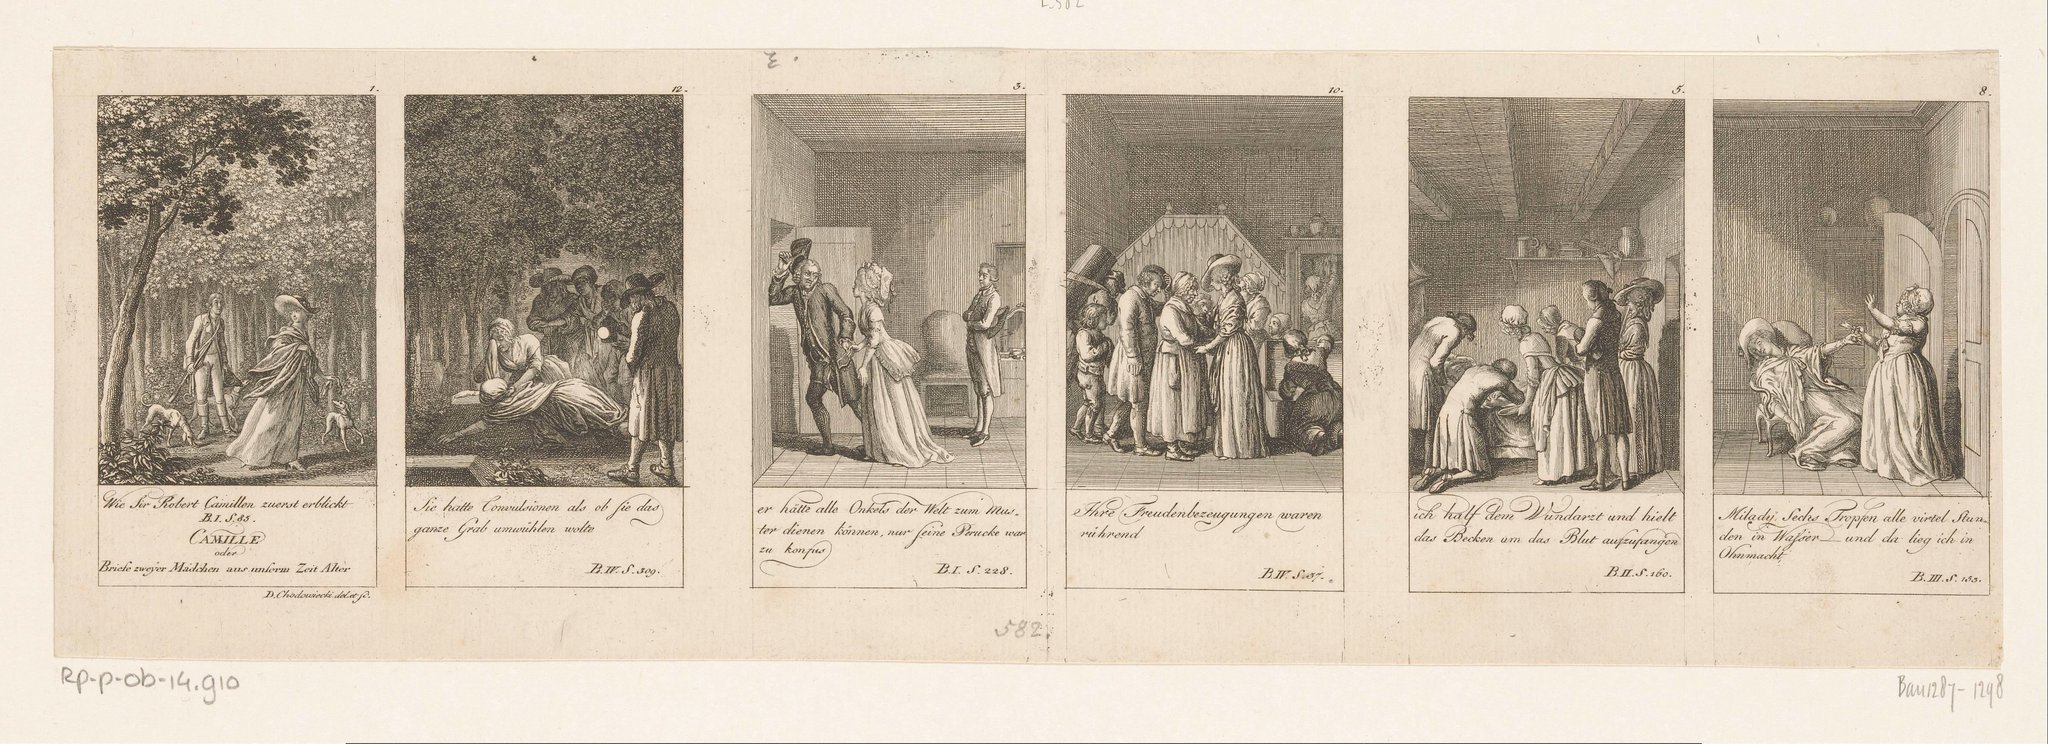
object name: print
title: Zes voorstellingen uit Camille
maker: daniel nikolaus chodowiecki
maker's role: draughtsman, print maker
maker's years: 1726-1801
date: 1787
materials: paper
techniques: etching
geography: berlin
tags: fainting, swooning, literature, walking the dog (+ variant), grave, tomb, weeping, meeting, nursing, tending the sick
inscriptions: collector's mark: Lugt 2228